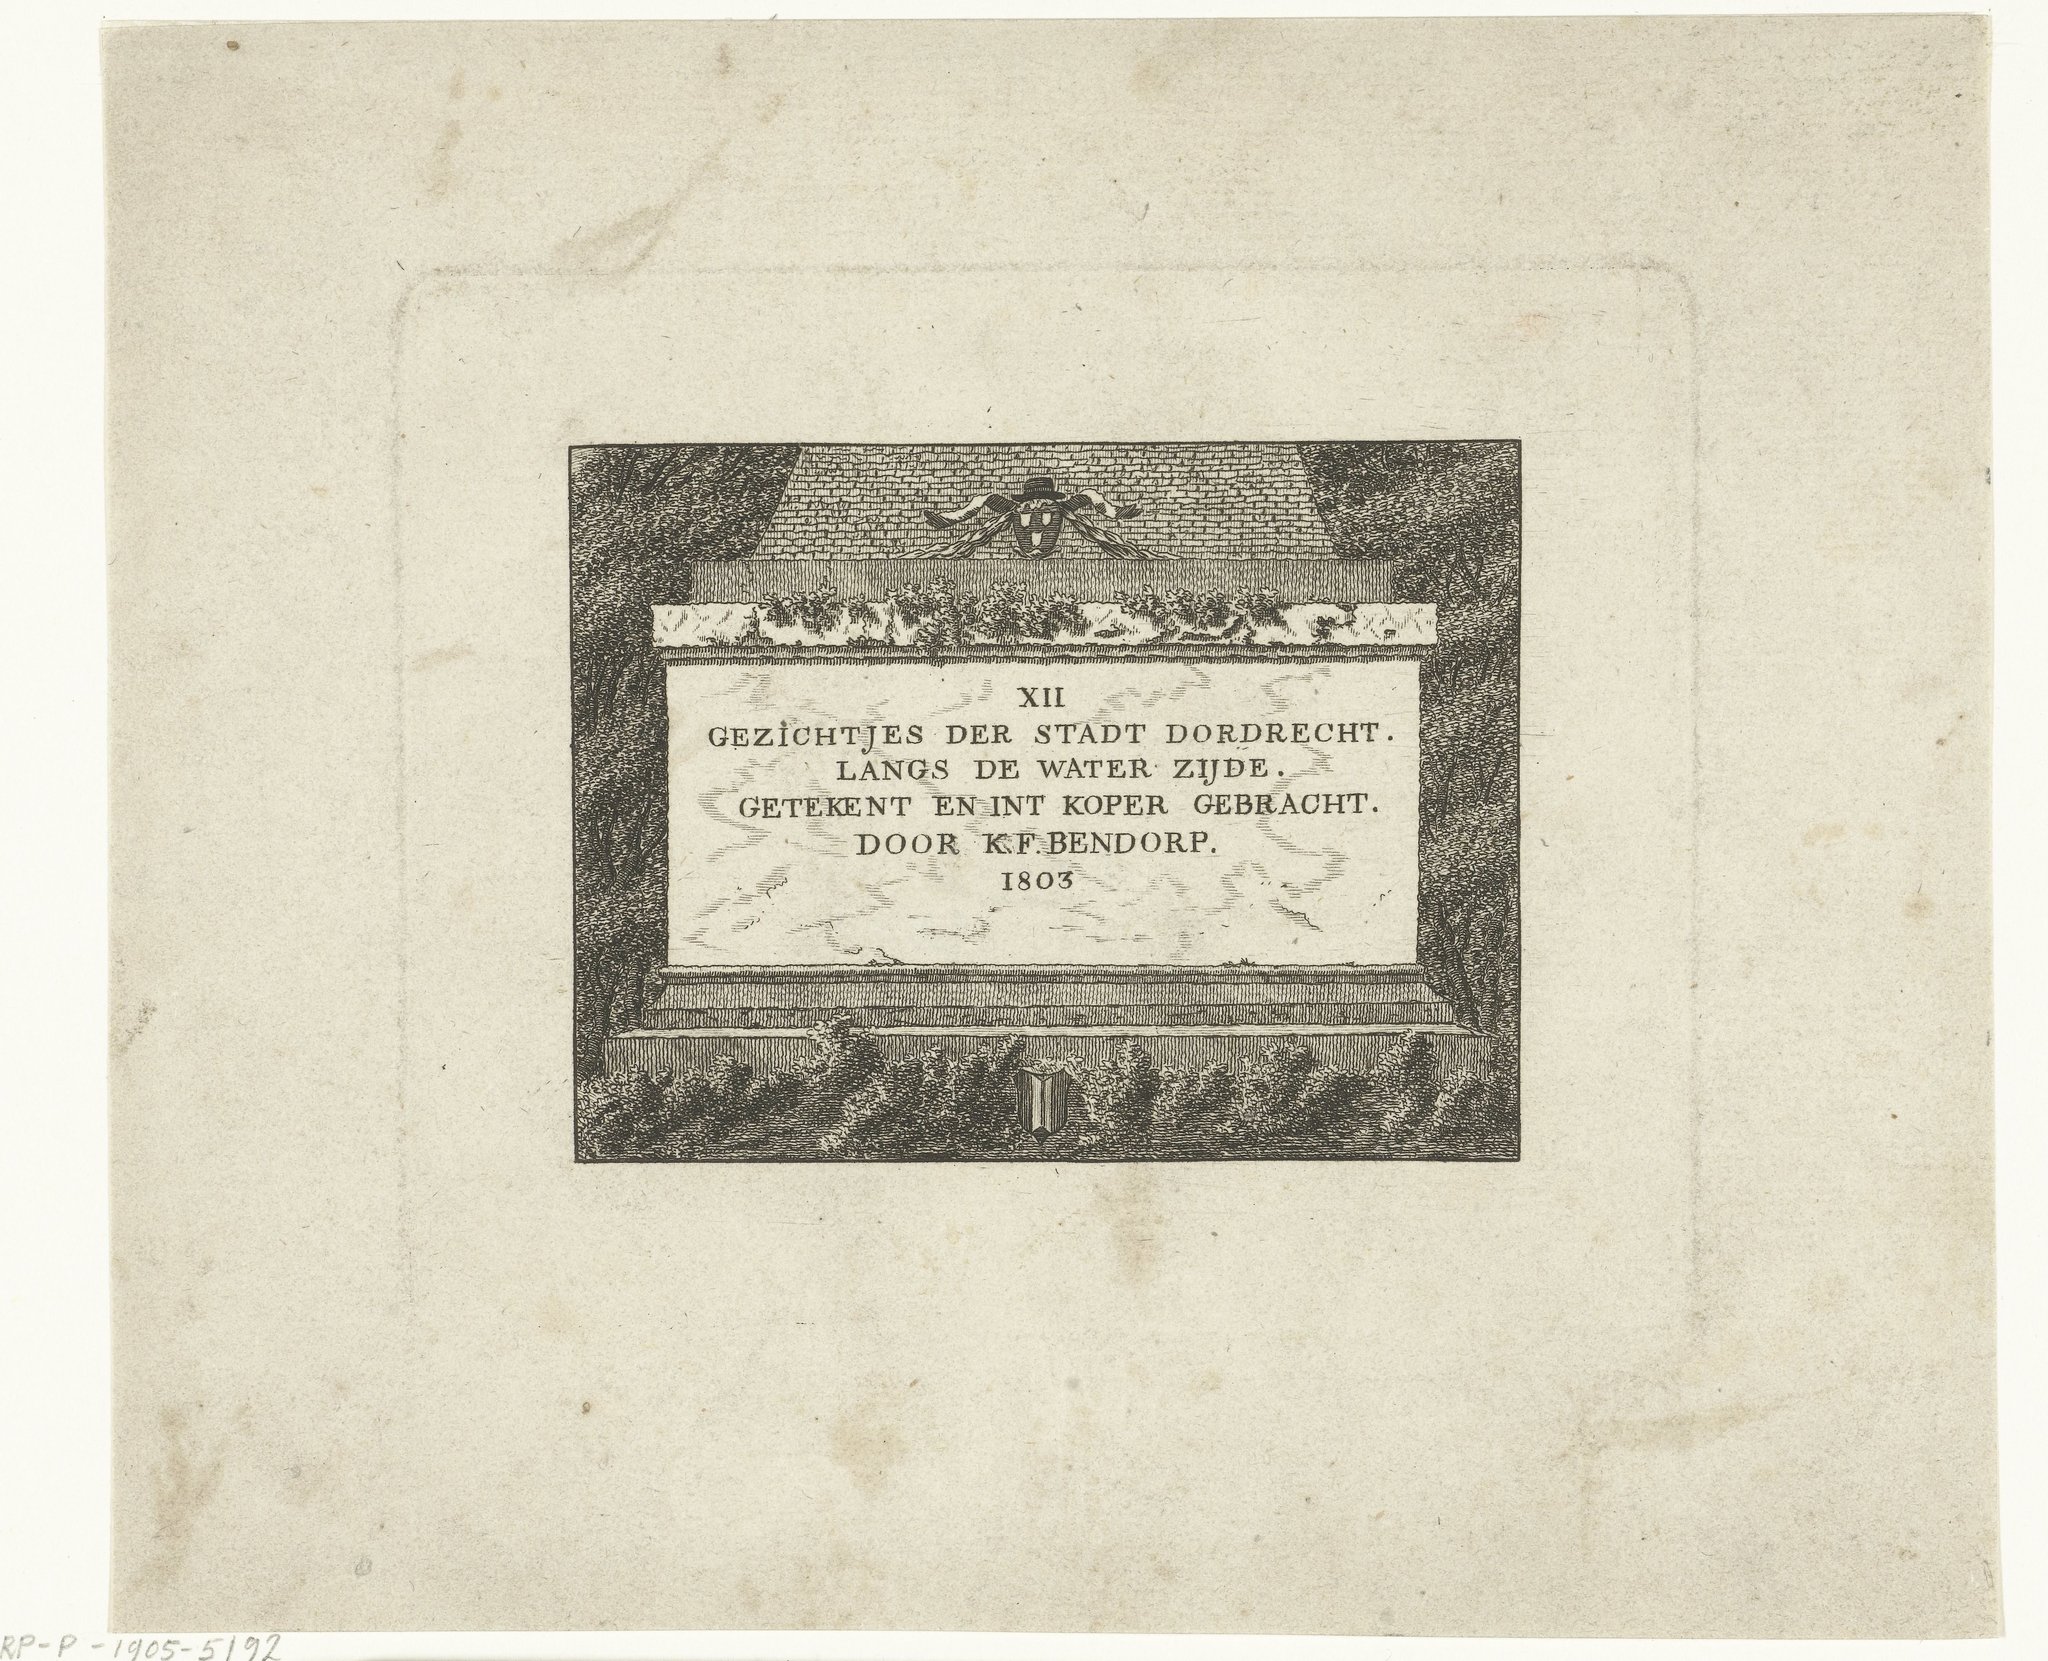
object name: print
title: Titelprent voor: XII Gezichtjes der Stadt Dordrecht Langs de water zijde, 1803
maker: carel frederik bendorp (i)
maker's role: print maker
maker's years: 1736-1814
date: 1803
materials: paper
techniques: etching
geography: dordrecht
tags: prospect of city, town panorama, silhouette of city, dordrecht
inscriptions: collector's mark: Lugt 2228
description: Titelprent uit: XII Gezichtjes der Stadt Dordrecht. Langs de water zijde. Getekent en int koper gebracht door K.F. Bendorp, 1803